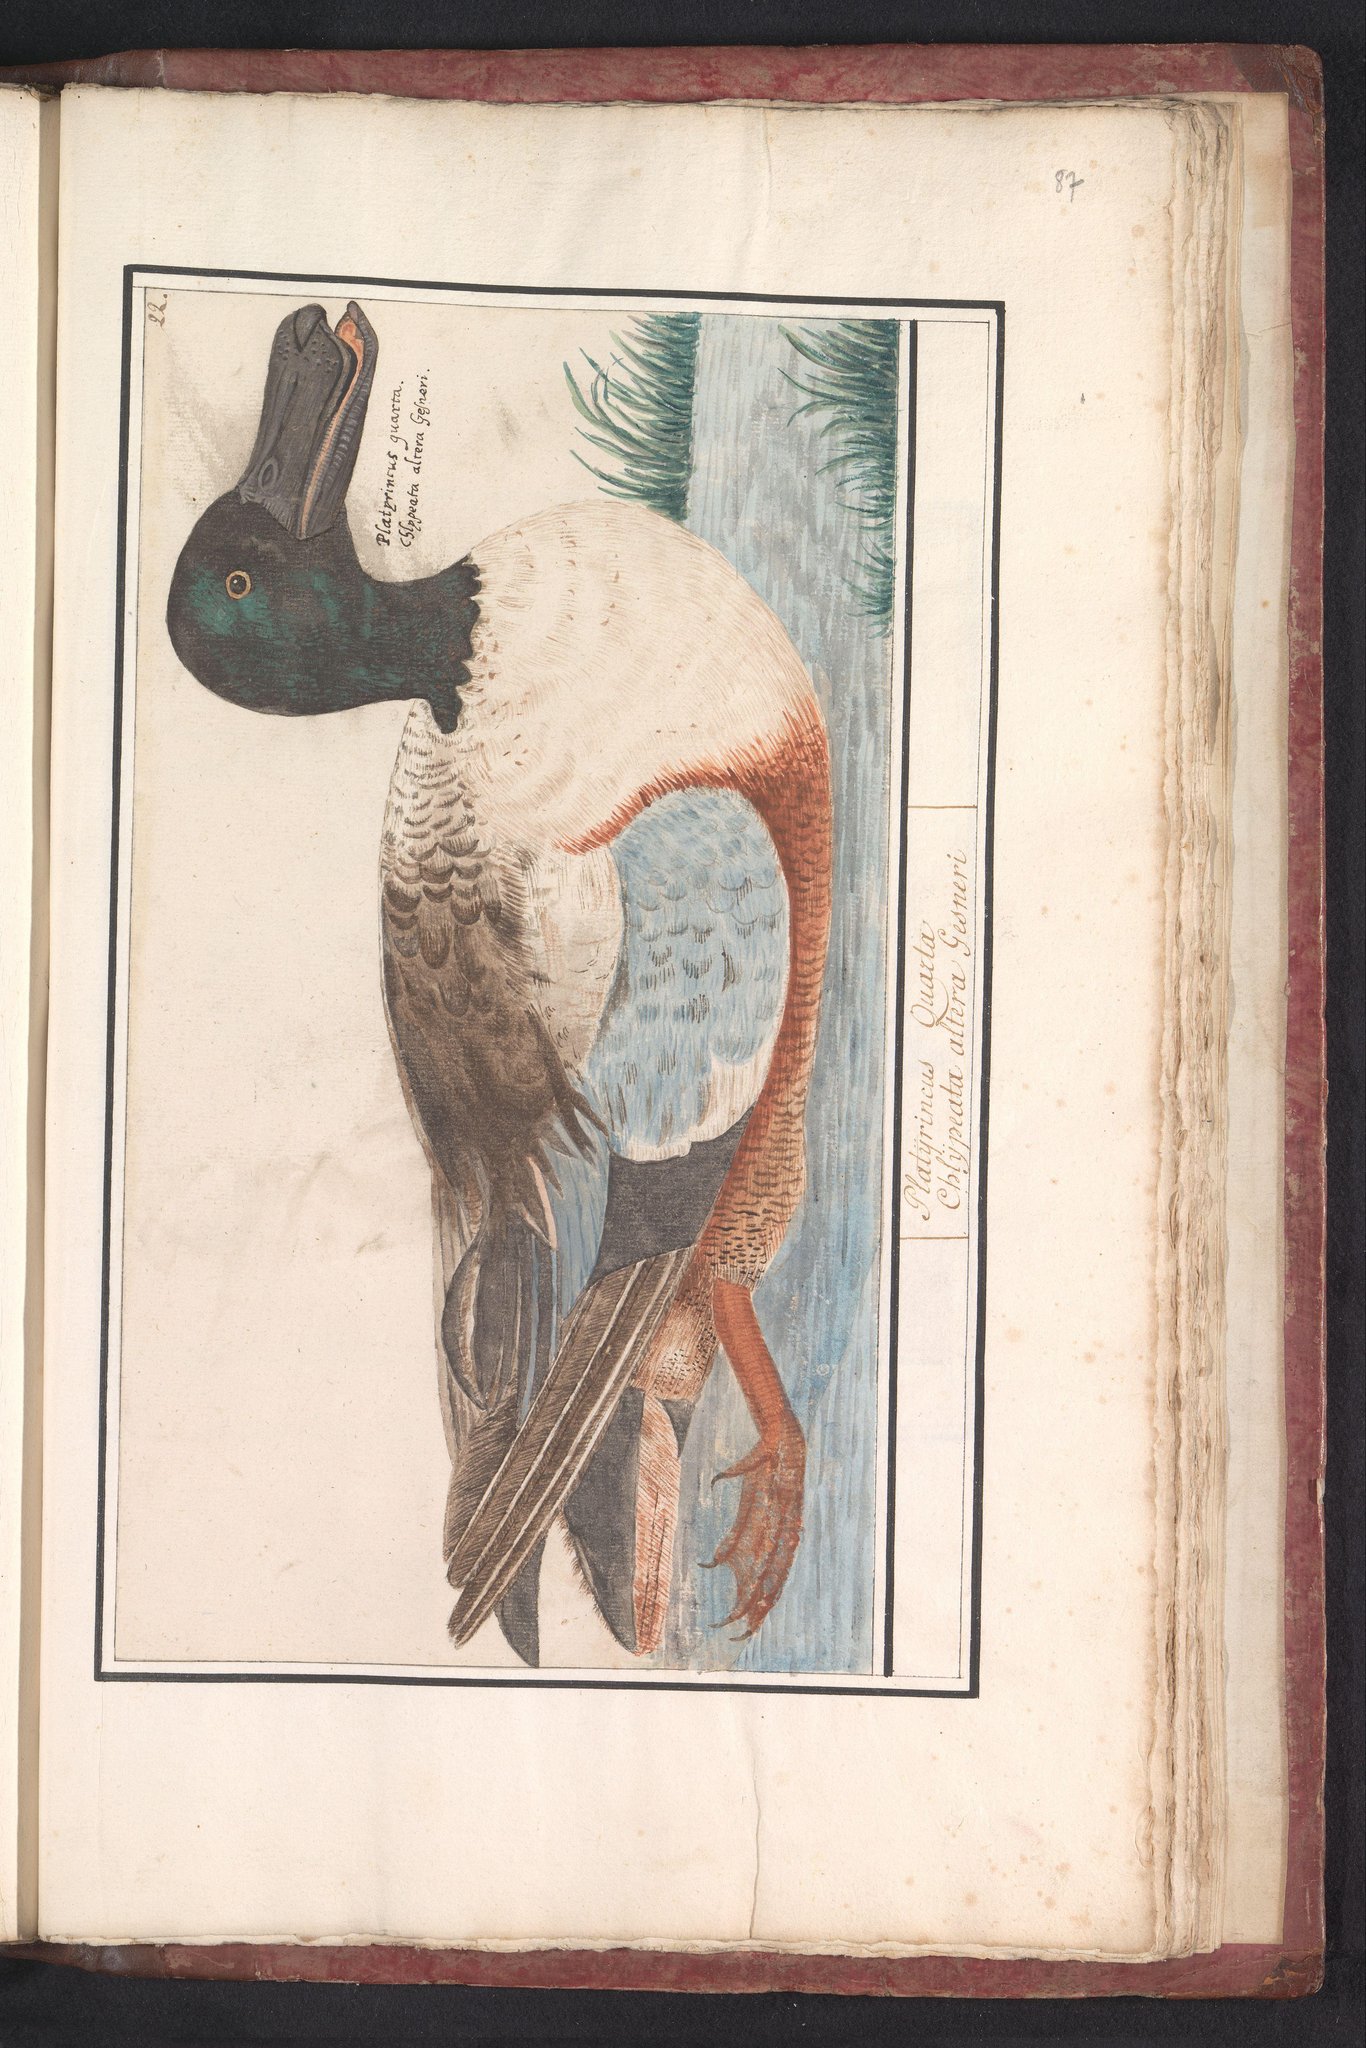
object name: drawing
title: Slobeend (Anas clypeata)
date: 1596-1610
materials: chalk, paint, ink, paper, pencil, watercolor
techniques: brush, pen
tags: water-birds: northern shoveler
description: Slobeend. Genummerd rechtsboven: 22. Hier ook de Latijnse naam. Onderdeel van het derde album met tekeningen van vogels. Vijfde van twaalf albums met tekeningen van dieren, vogels en planten bekend rond 1600, gemaakt in opdracht van keizer Rudolf II. Met toelichting in Nederlands, Latijn en Frans.